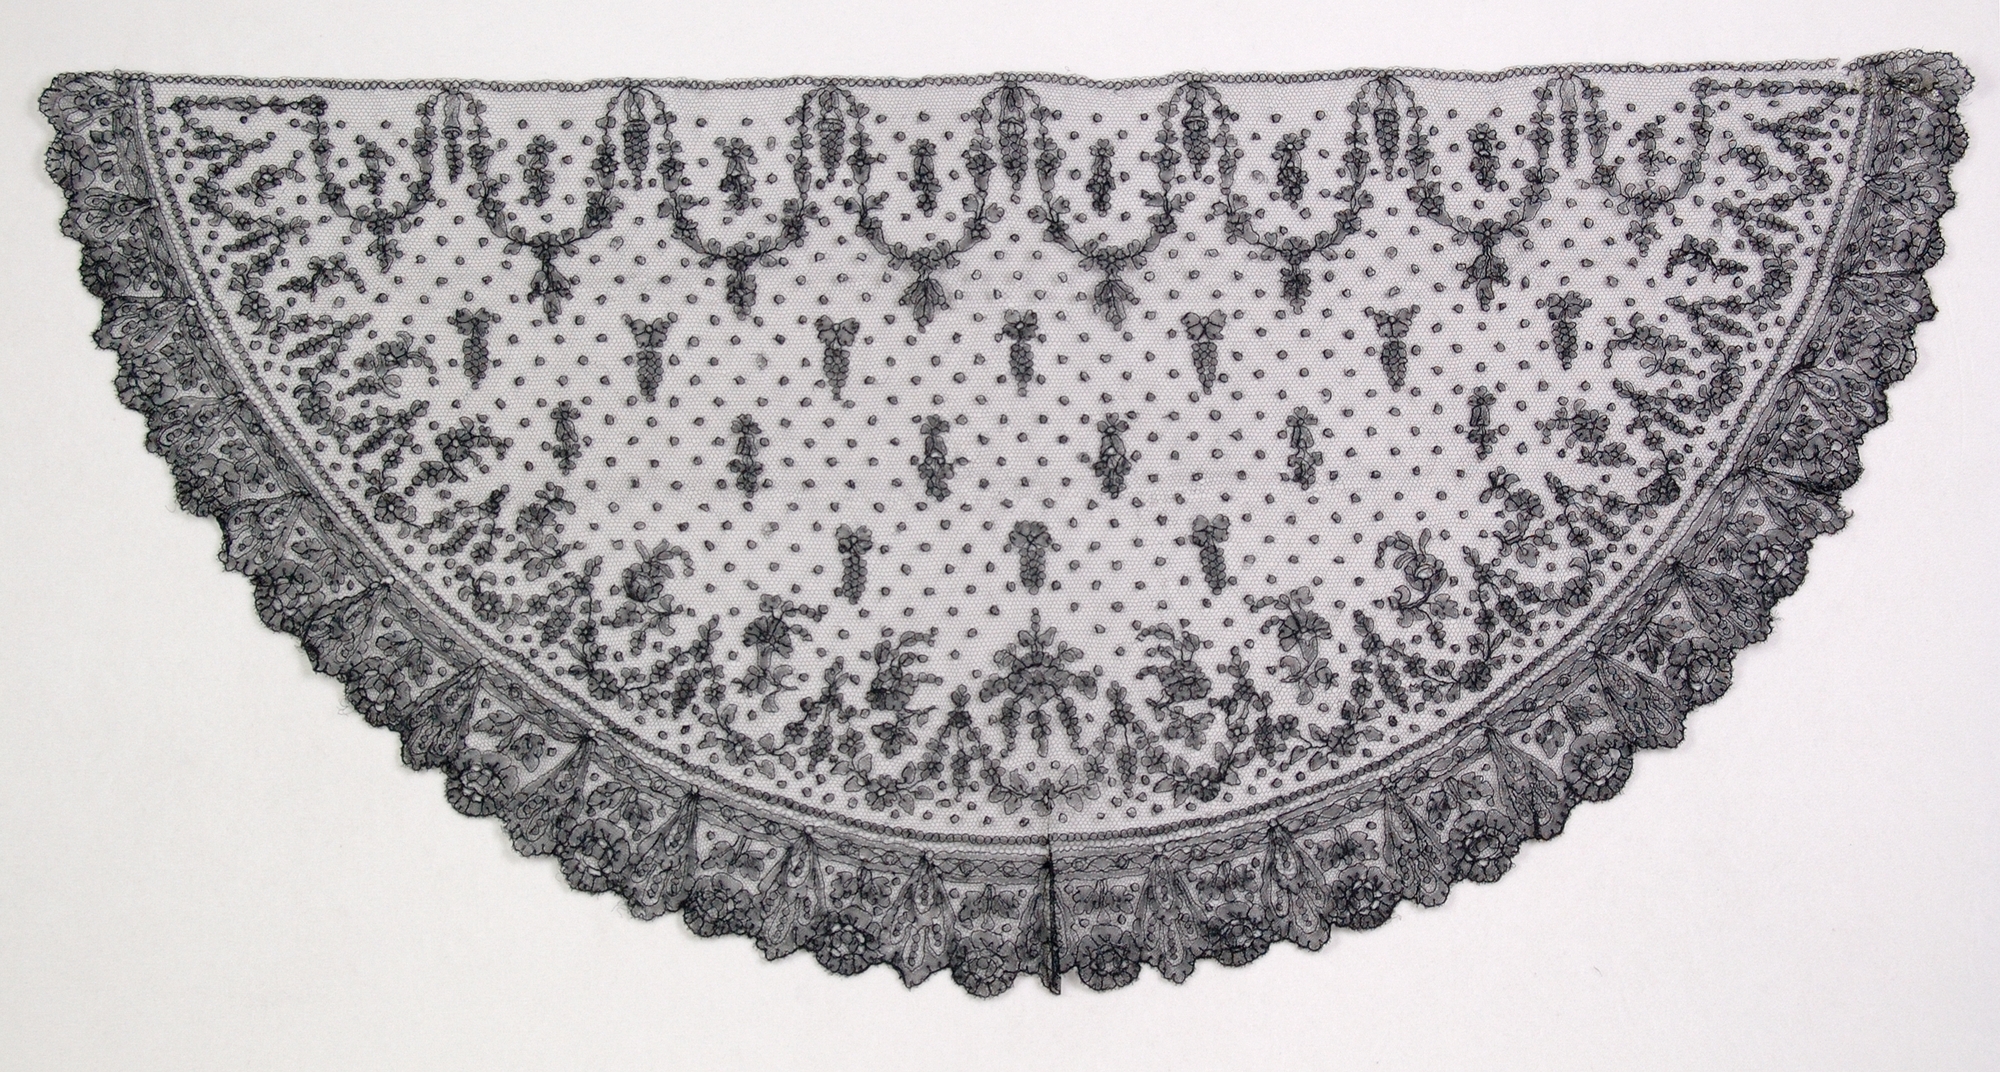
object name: veil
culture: french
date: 1840-1860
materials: silk